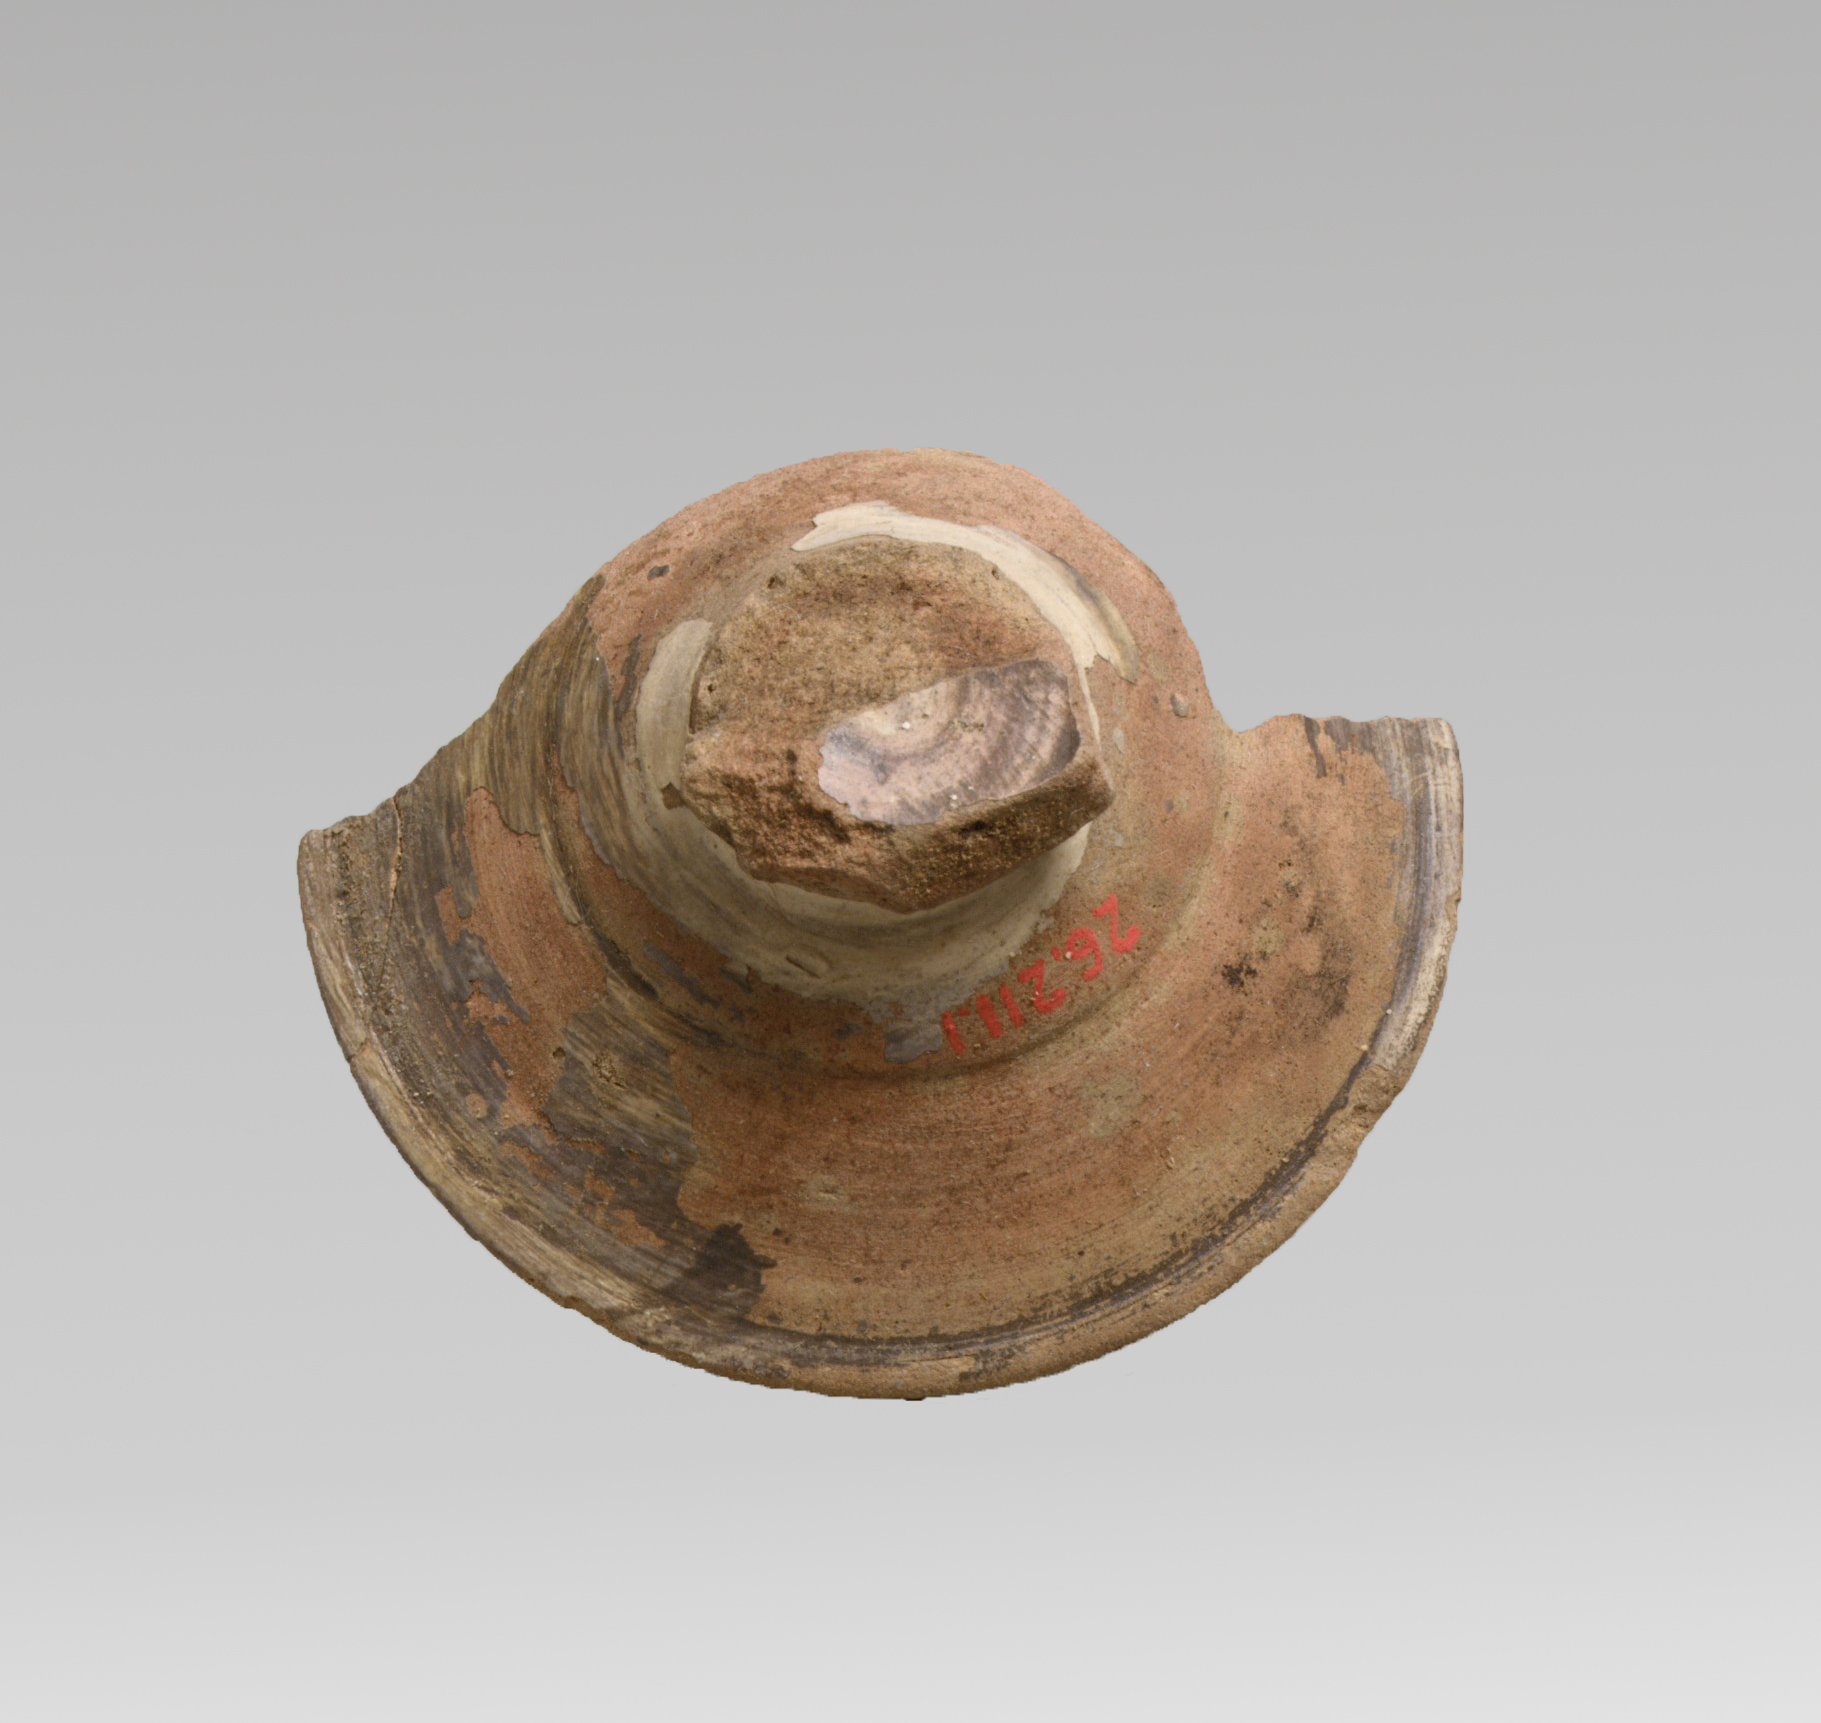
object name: vase fragment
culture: east greek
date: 700-601 BCE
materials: terracotta